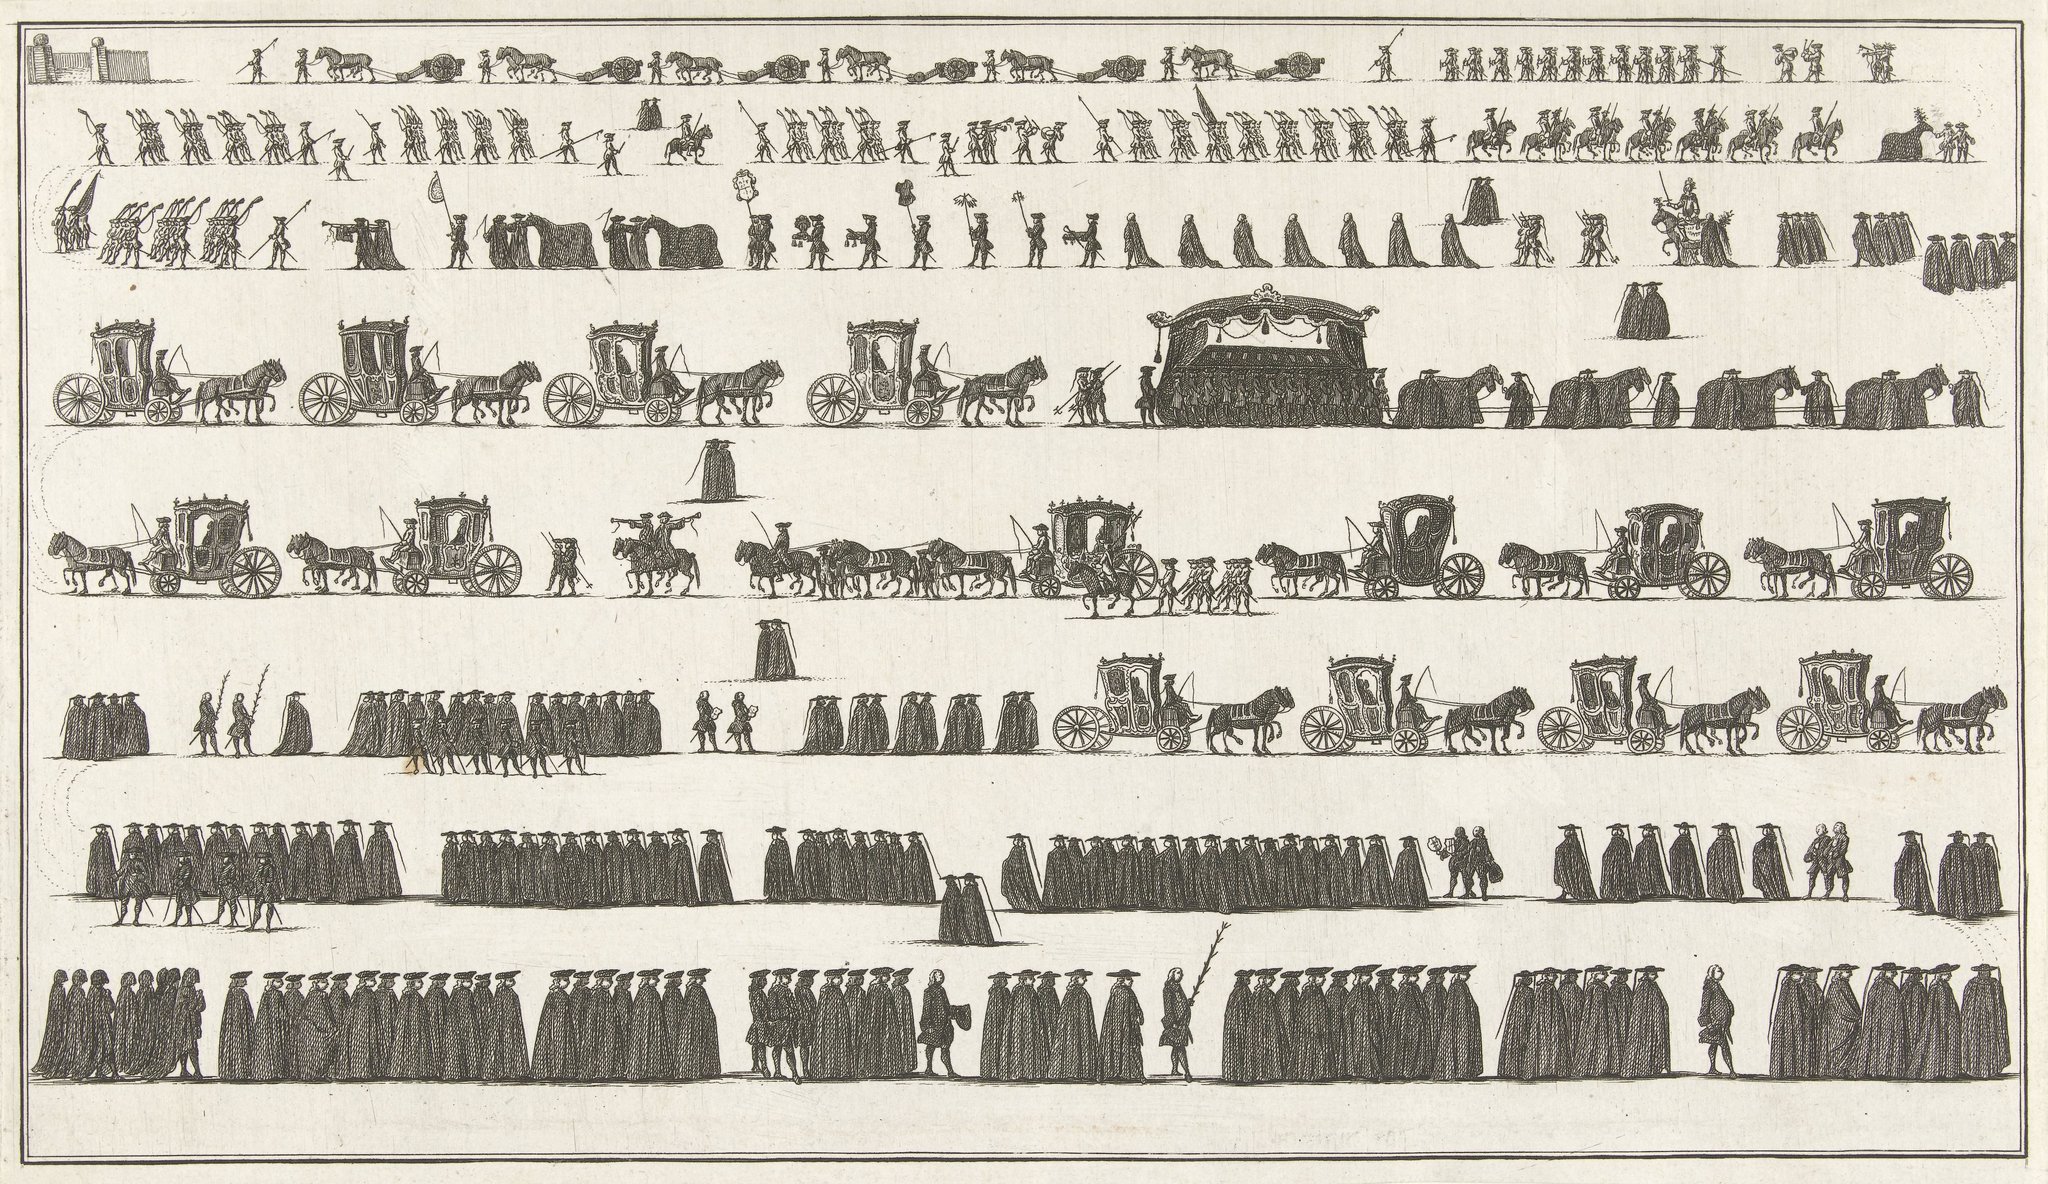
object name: print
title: Lijkstatie van Jacob Mossel, Governeur-Generaal te Batavia, 1761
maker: Anonymous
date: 1762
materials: paper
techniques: etching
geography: northern netherlands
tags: enkhuizen, batavia, cortege, funeral procession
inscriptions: collector's mark: Lugt 2228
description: De lijkstatie bij de begrafenis van Jacob Mossel, de Governeur-Generaal te Batavia, 19 mei 1761. De stoet afgebeeld in 8 rijen onder elkaar, details nog ongenummerd.